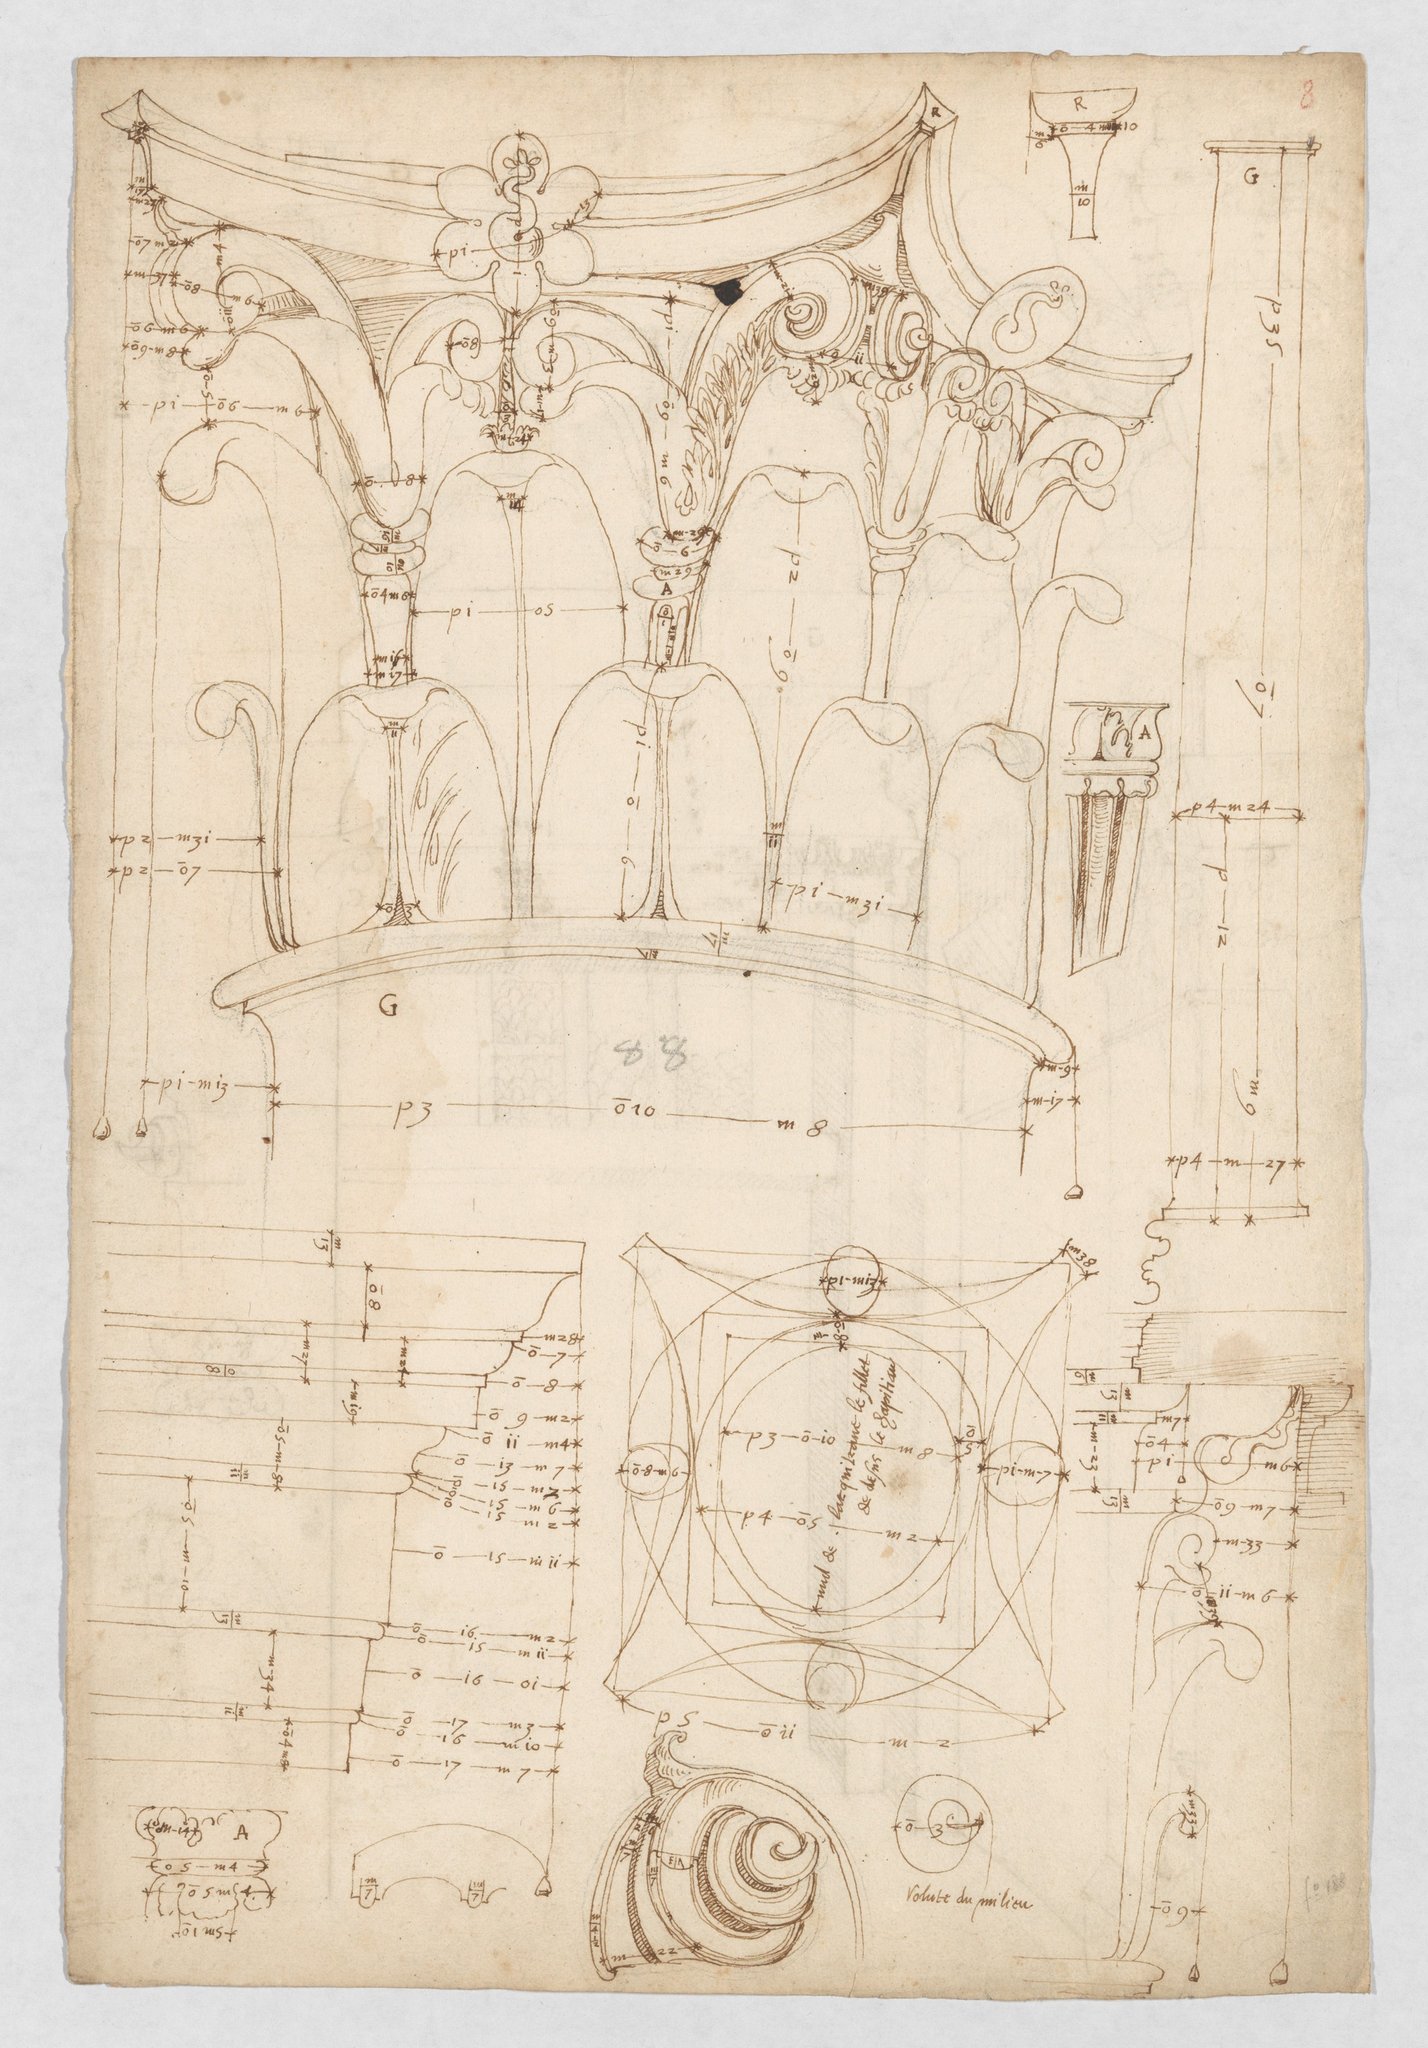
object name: collection ornament architecture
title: Pantheon, portico, Corinthian column capital, projection, plan, and details; column shaft, profile; beam architrave, elevation (recto) Pantheon, cella, perspective, details; vault, details; portal, interior, cornice, profile (verso)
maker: anonymous, french, 16th century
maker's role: draftsman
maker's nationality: french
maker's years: 1500-1600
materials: chalk, ink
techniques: incising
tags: architecture,columns